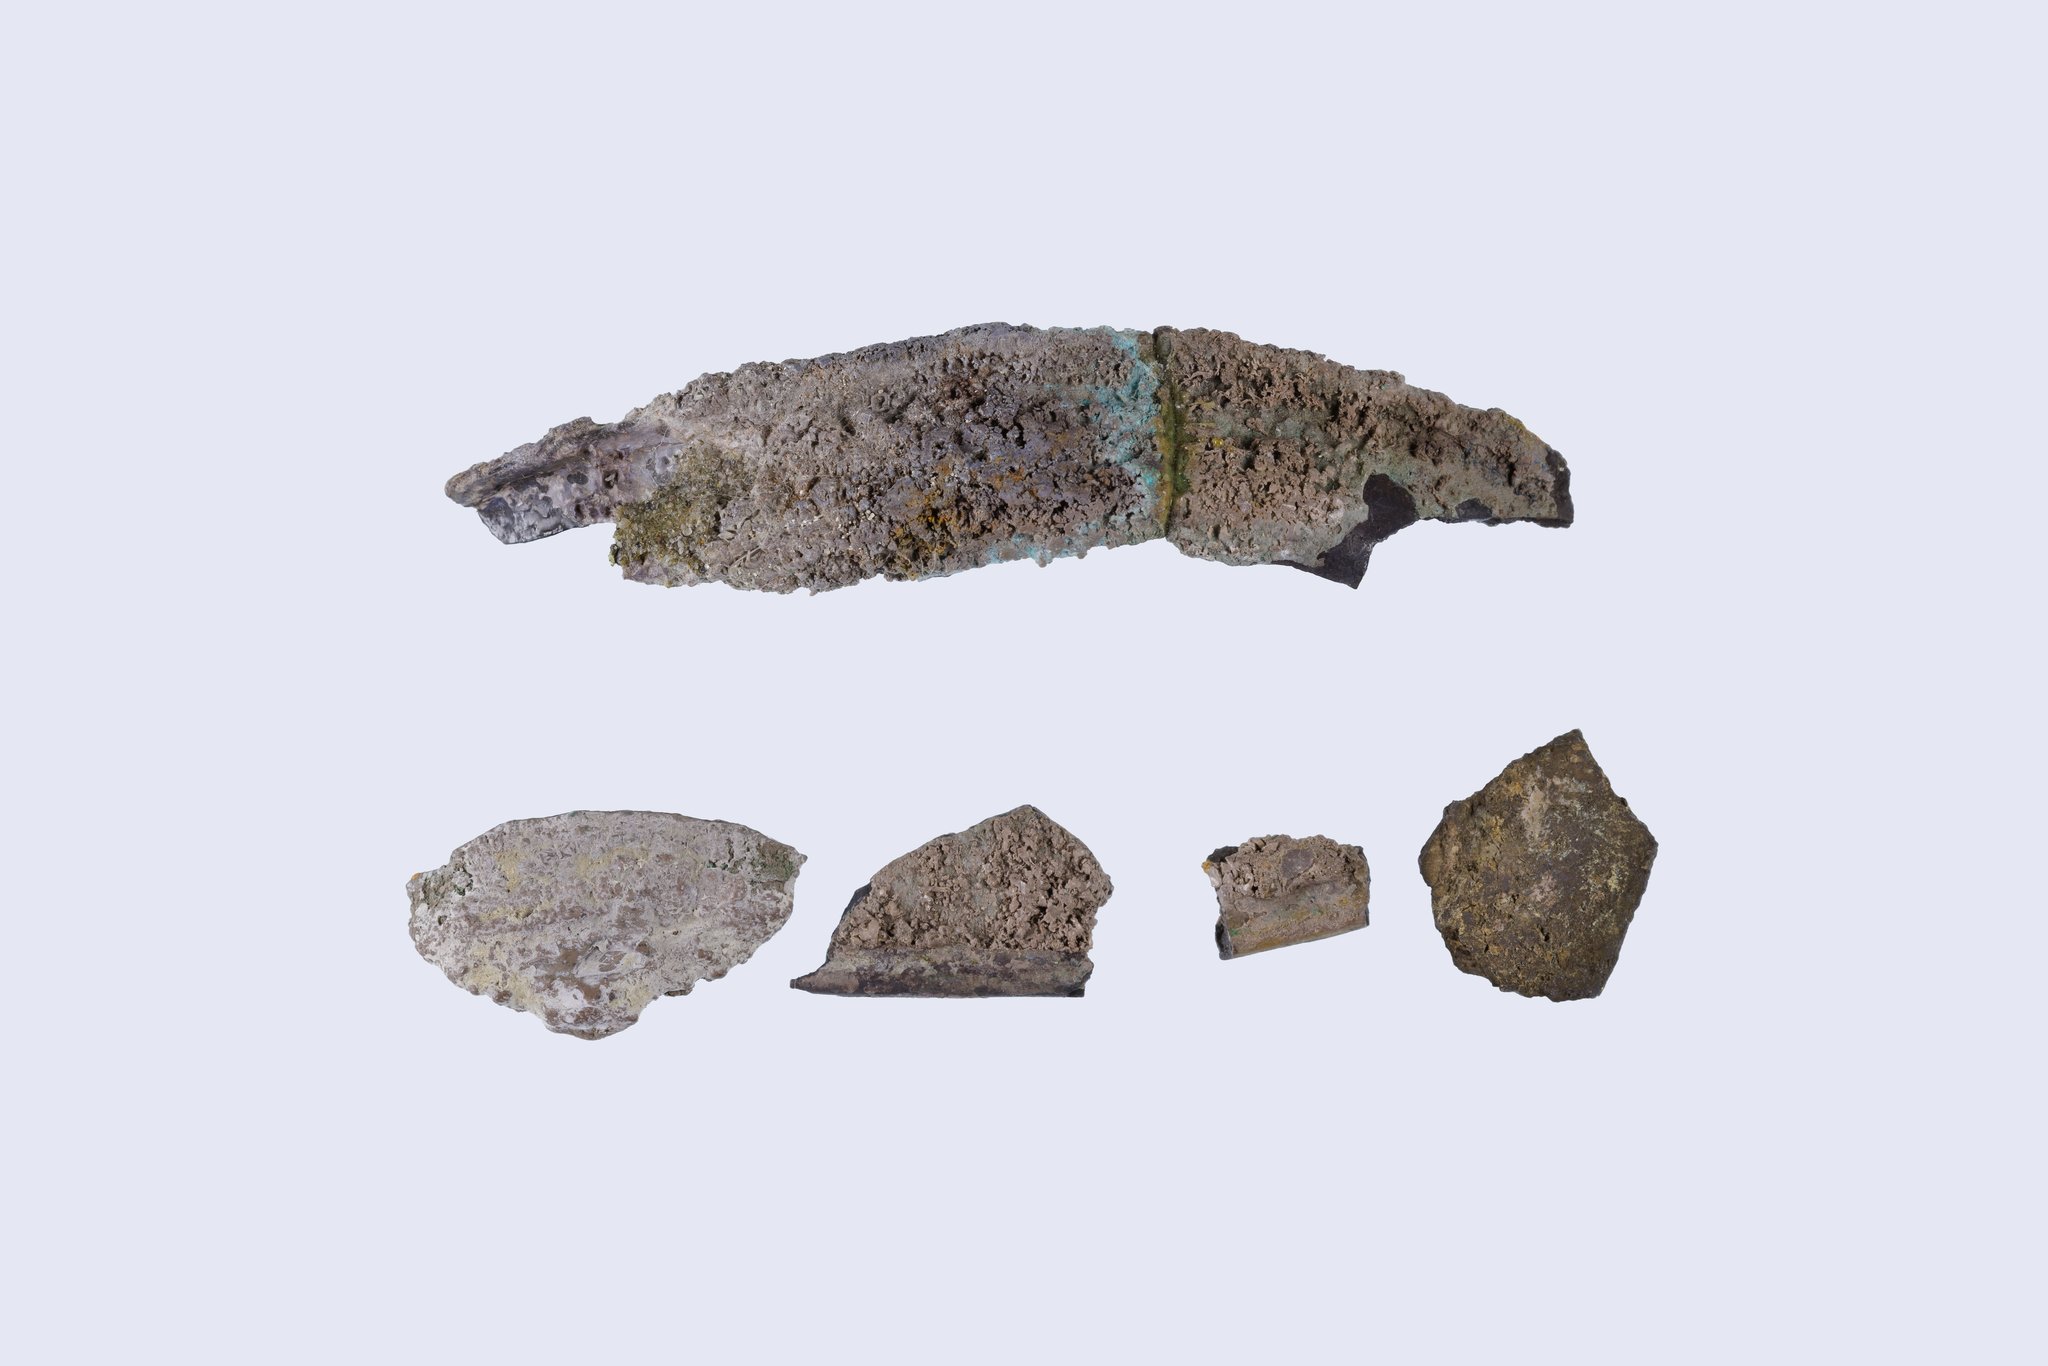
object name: vessel fragment, tell basta treasure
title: Vessel fragments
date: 1070-712 BCE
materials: silver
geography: egypt